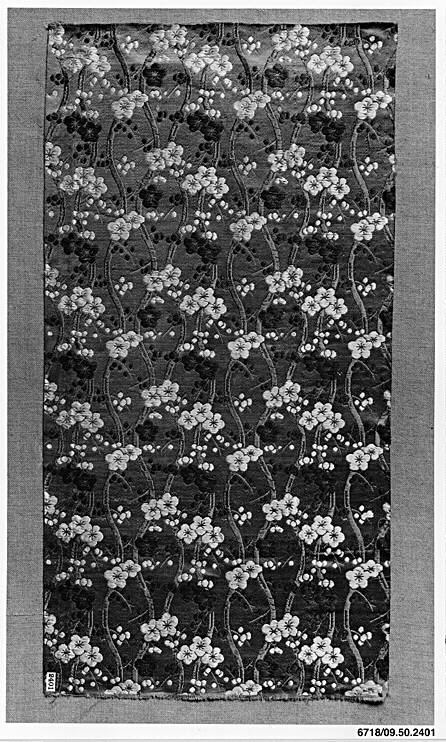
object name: piece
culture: japanese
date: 1801-1900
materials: silk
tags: flowers